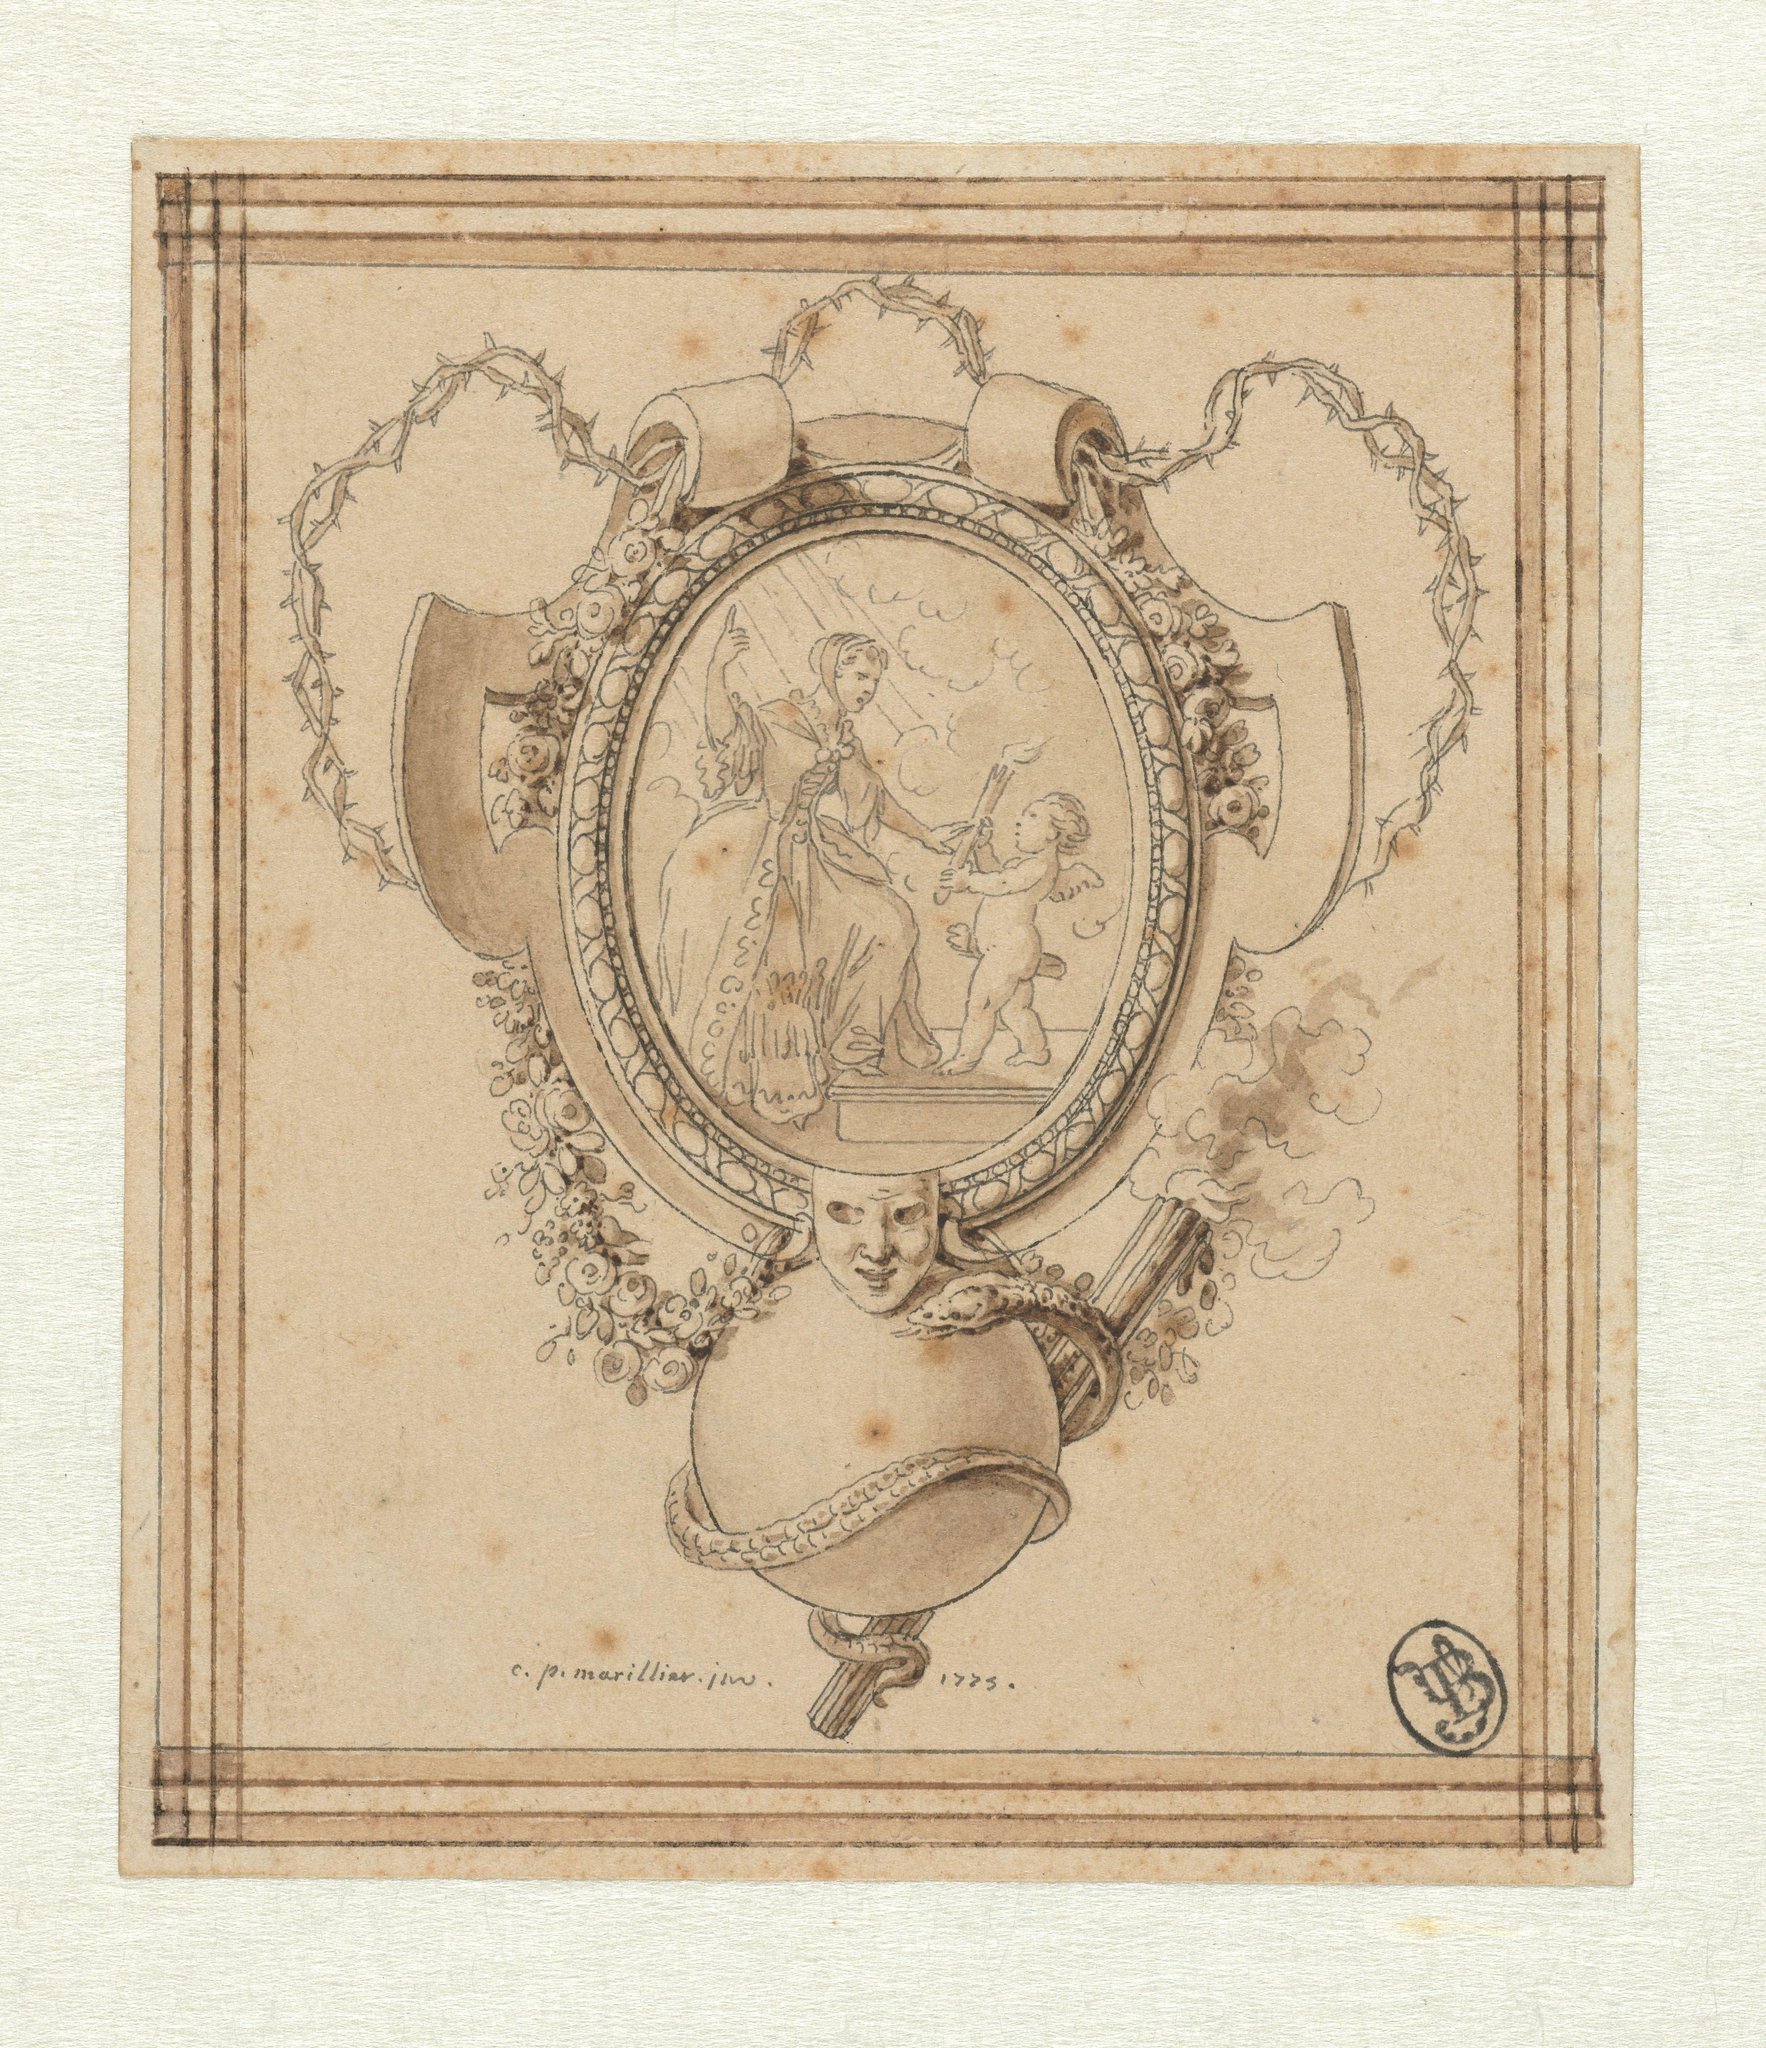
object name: design drawing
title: Ontwerp voor een vignet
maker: clément pierre marillier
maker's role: draughtsman, print maker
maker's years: 1740-1808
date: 1775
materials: graphite, ink, paper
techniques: brush, pen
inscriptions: signature and date, recto, lower centre, pen and brown ink: ‘c. p. marillier. inv. 1775.’, collector's mark, verso, lower right: Lugt 2228, collector's mark, recto, lower right: Lugt 421